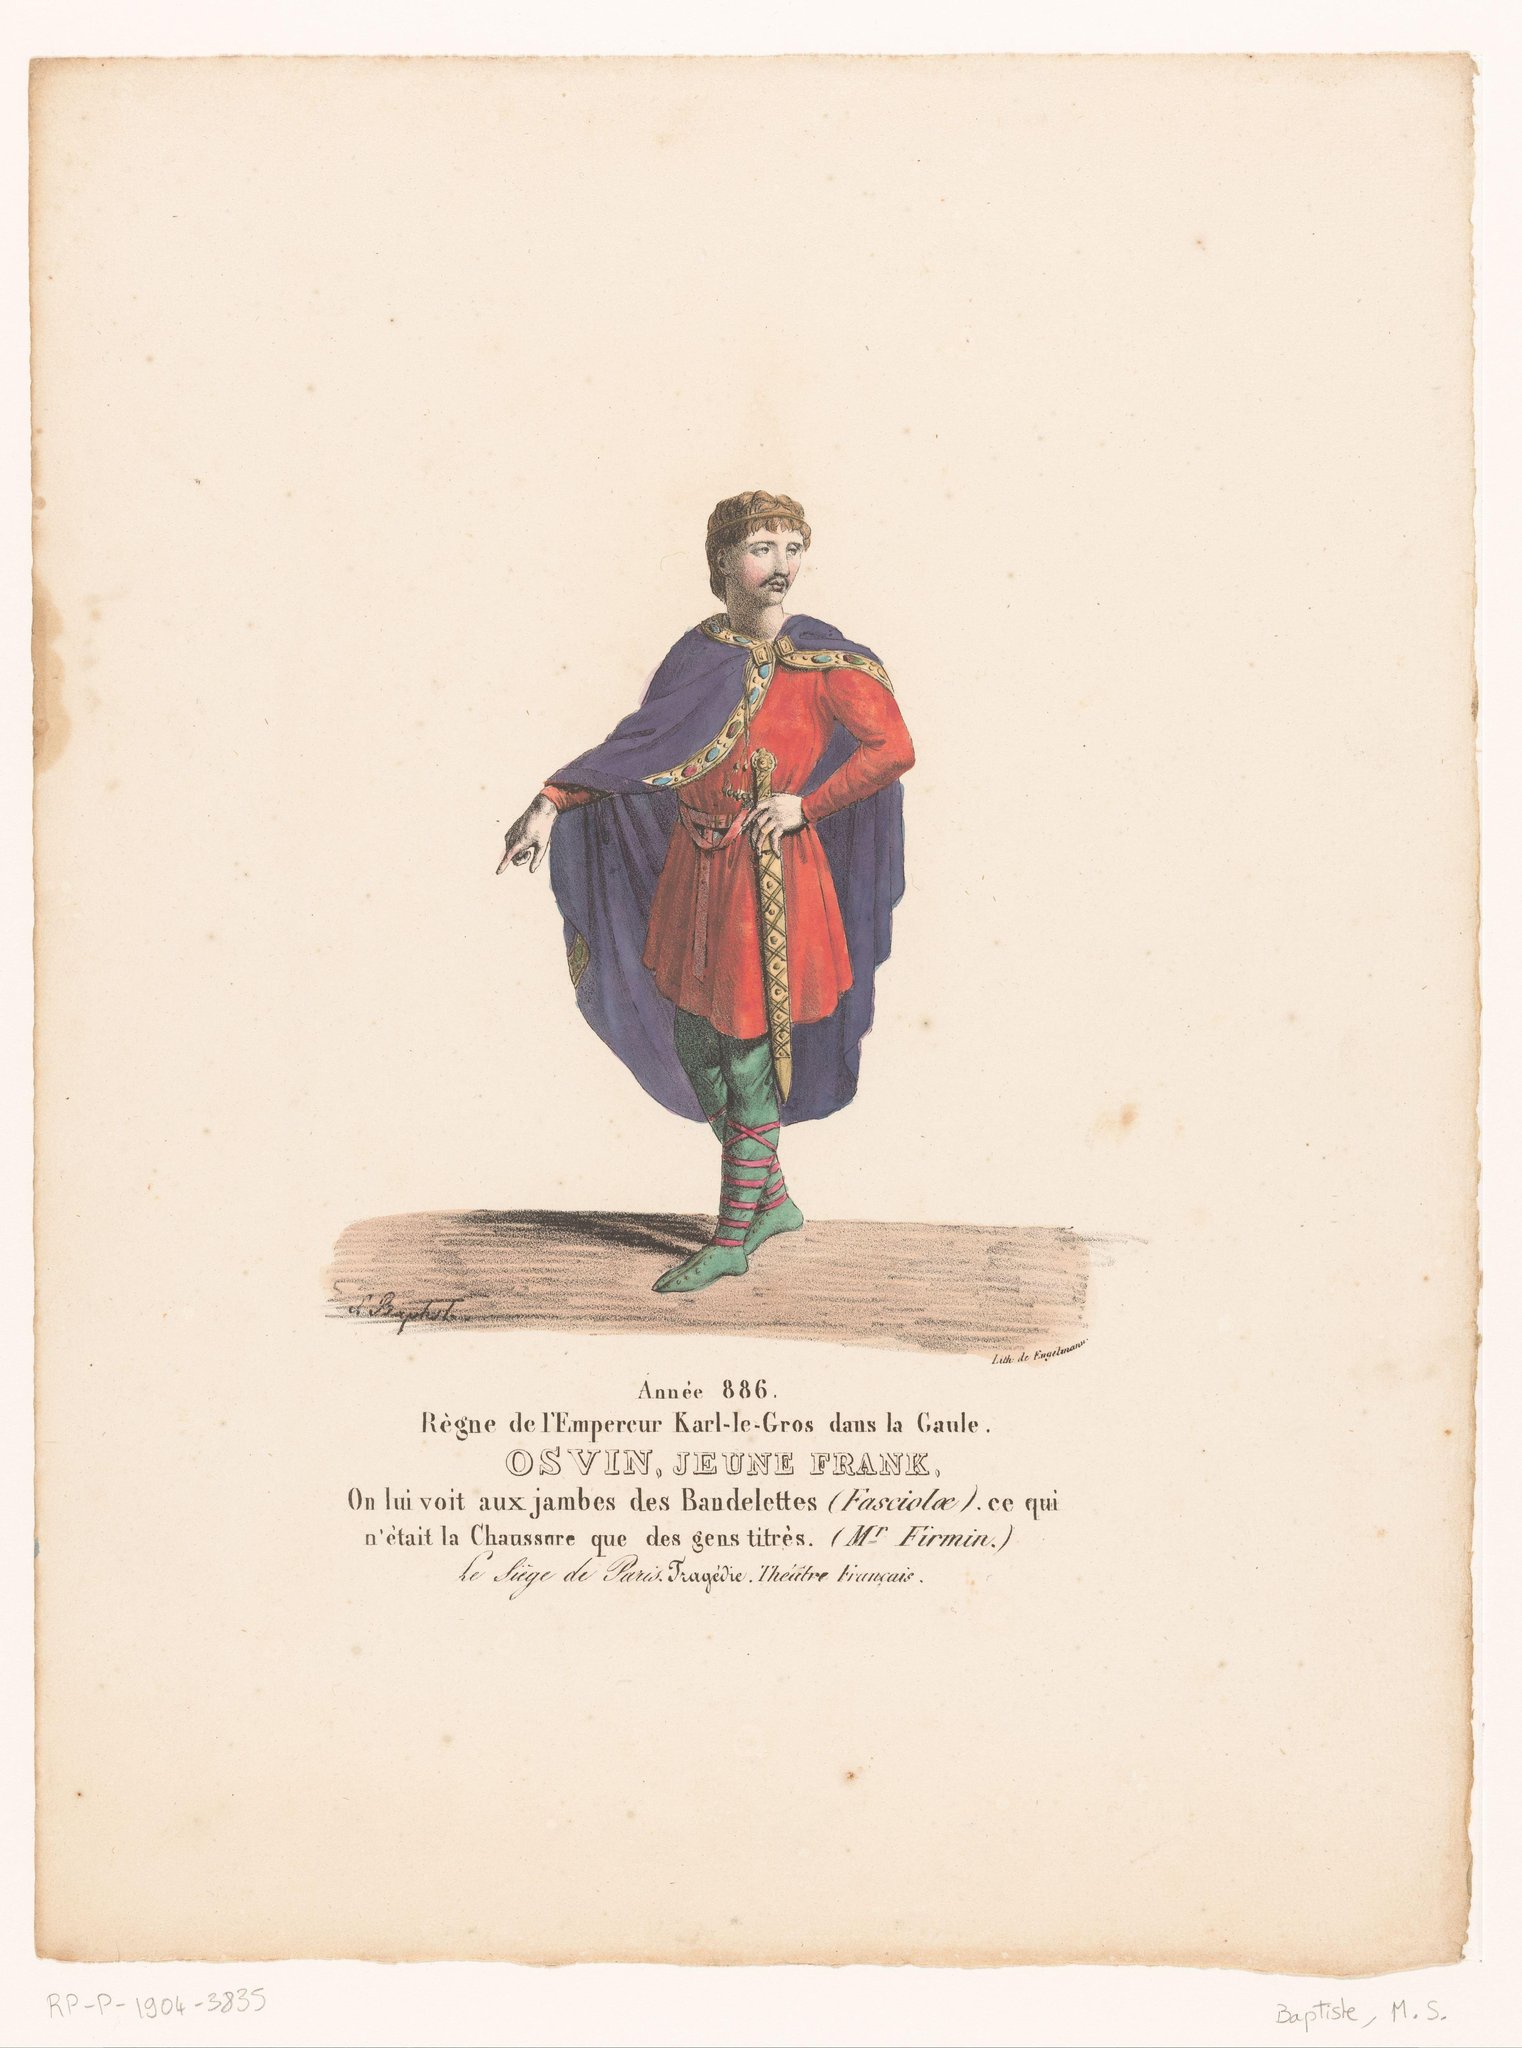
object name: print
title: Theaterkostuums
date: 1826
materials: paper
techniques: hand coloring, lithograph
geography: paris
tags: stage costume, actor (on the stage), tragedy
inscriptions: collector's mark: Lugt 2228a